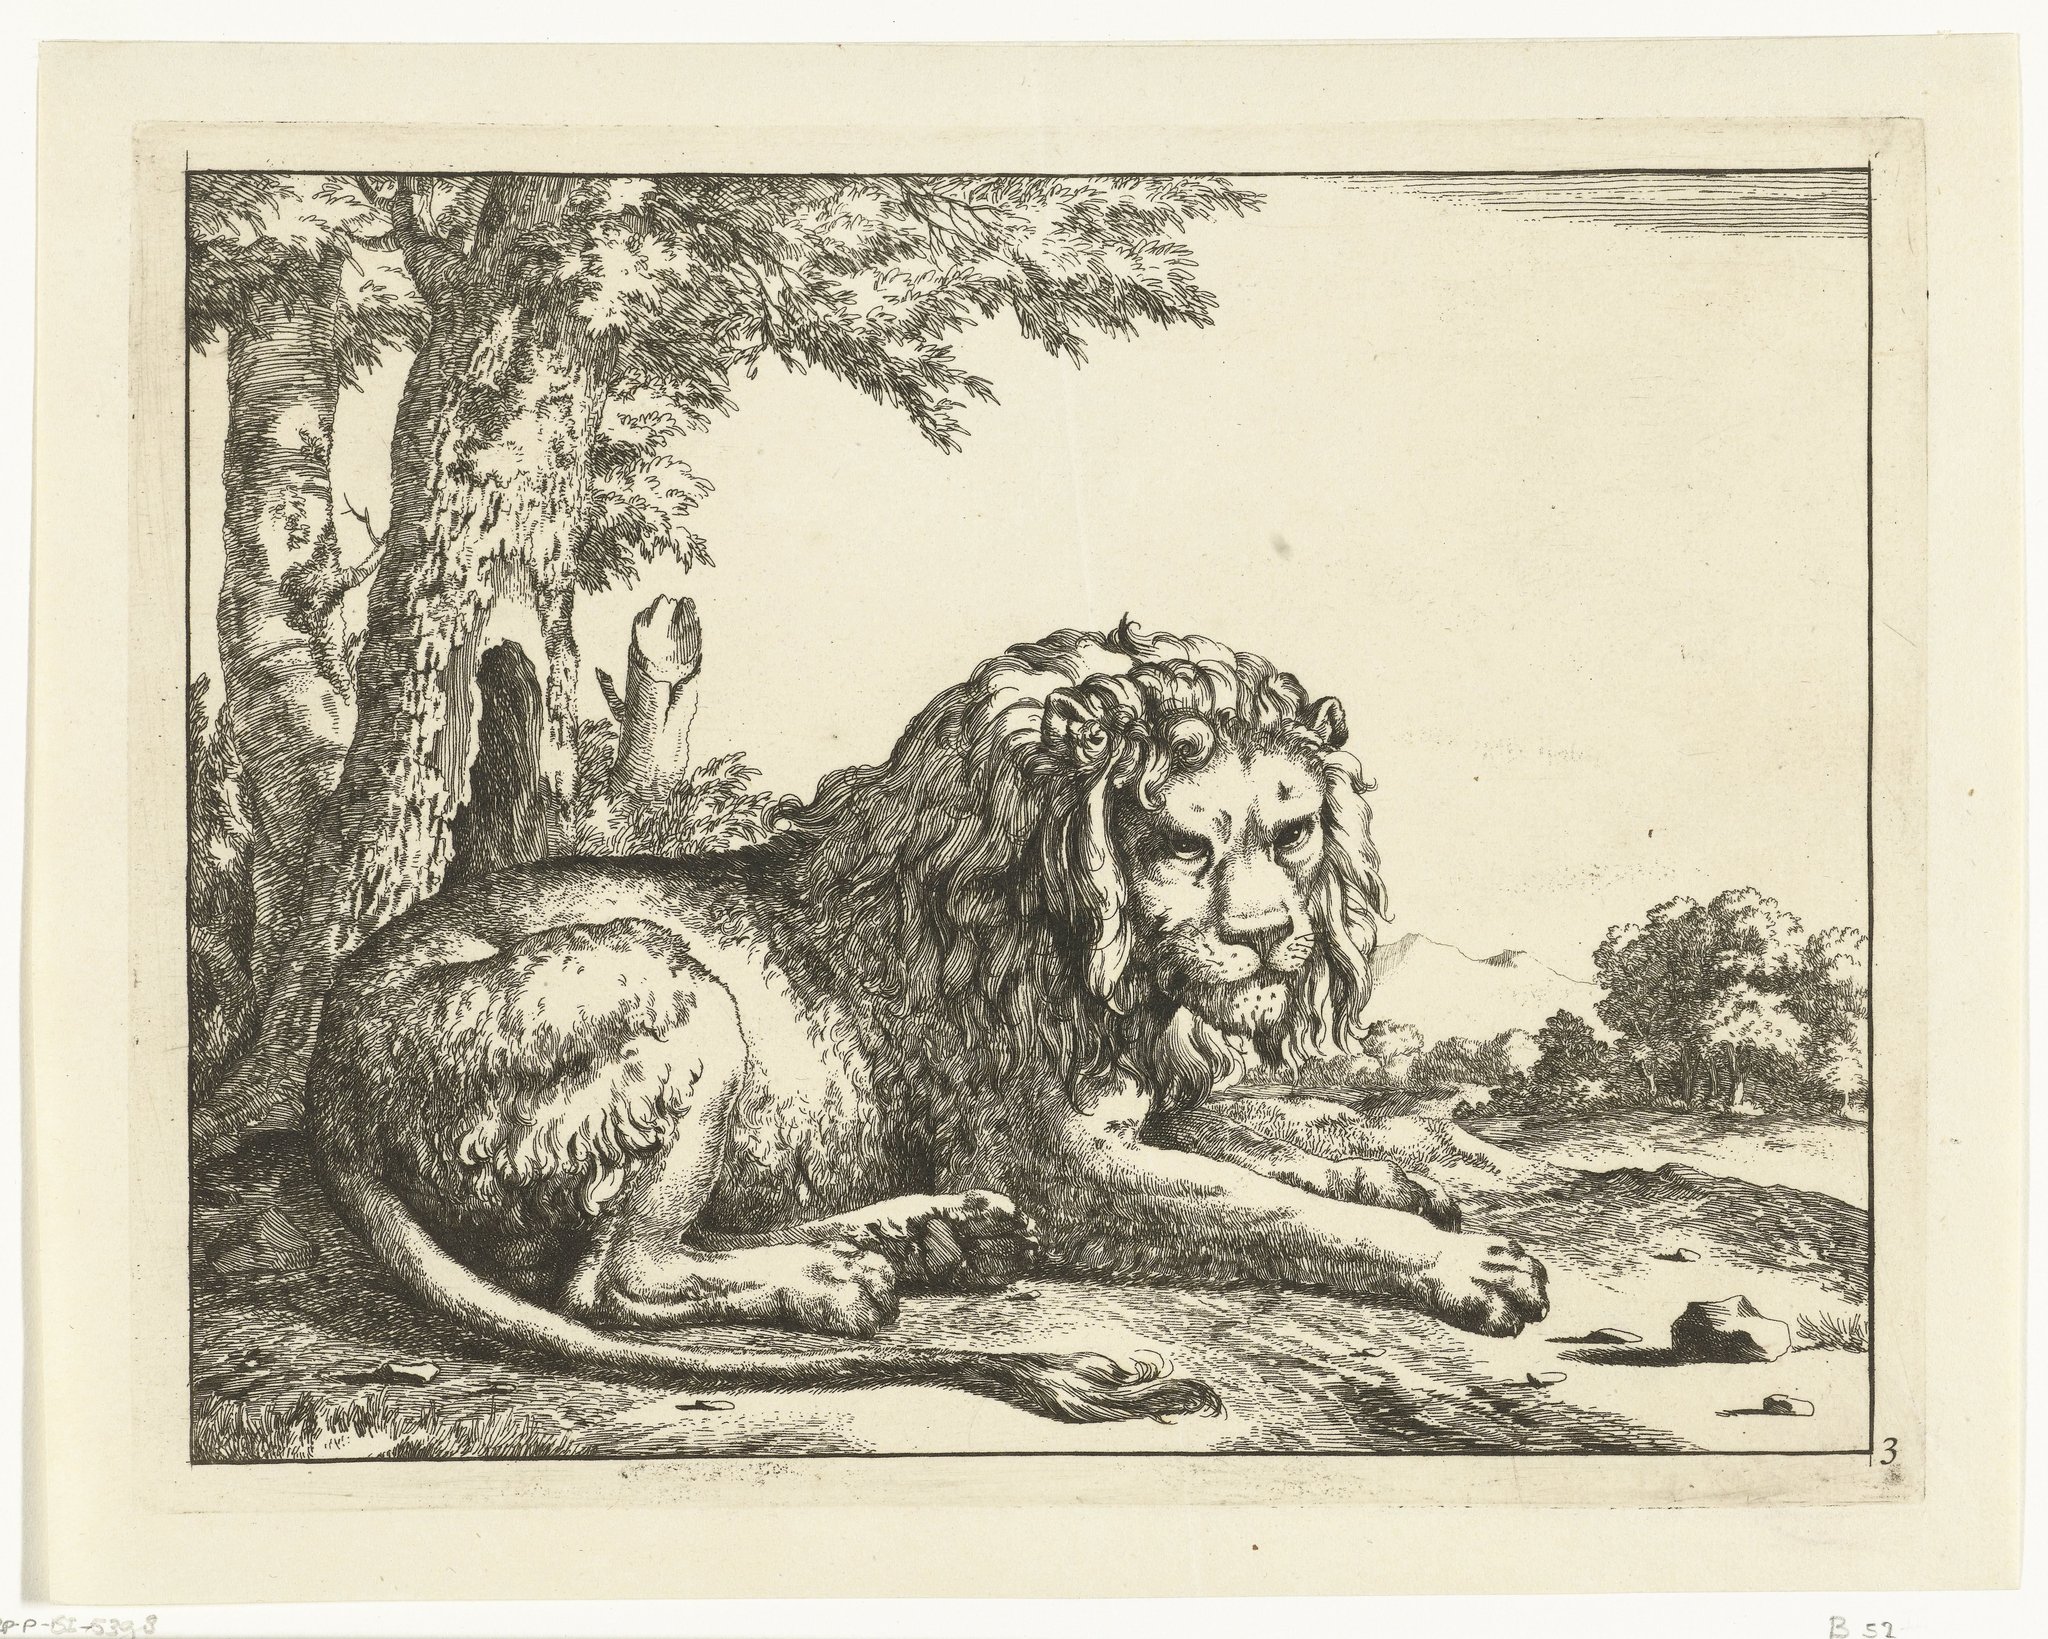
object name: print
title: Leeuwen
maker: marcus de bye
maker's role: print maker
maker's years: 1639-1688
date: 1664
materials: paper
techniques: etching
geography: the hague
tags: beasts of prey, predatory animals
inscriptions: collector's mark: Lugt 240